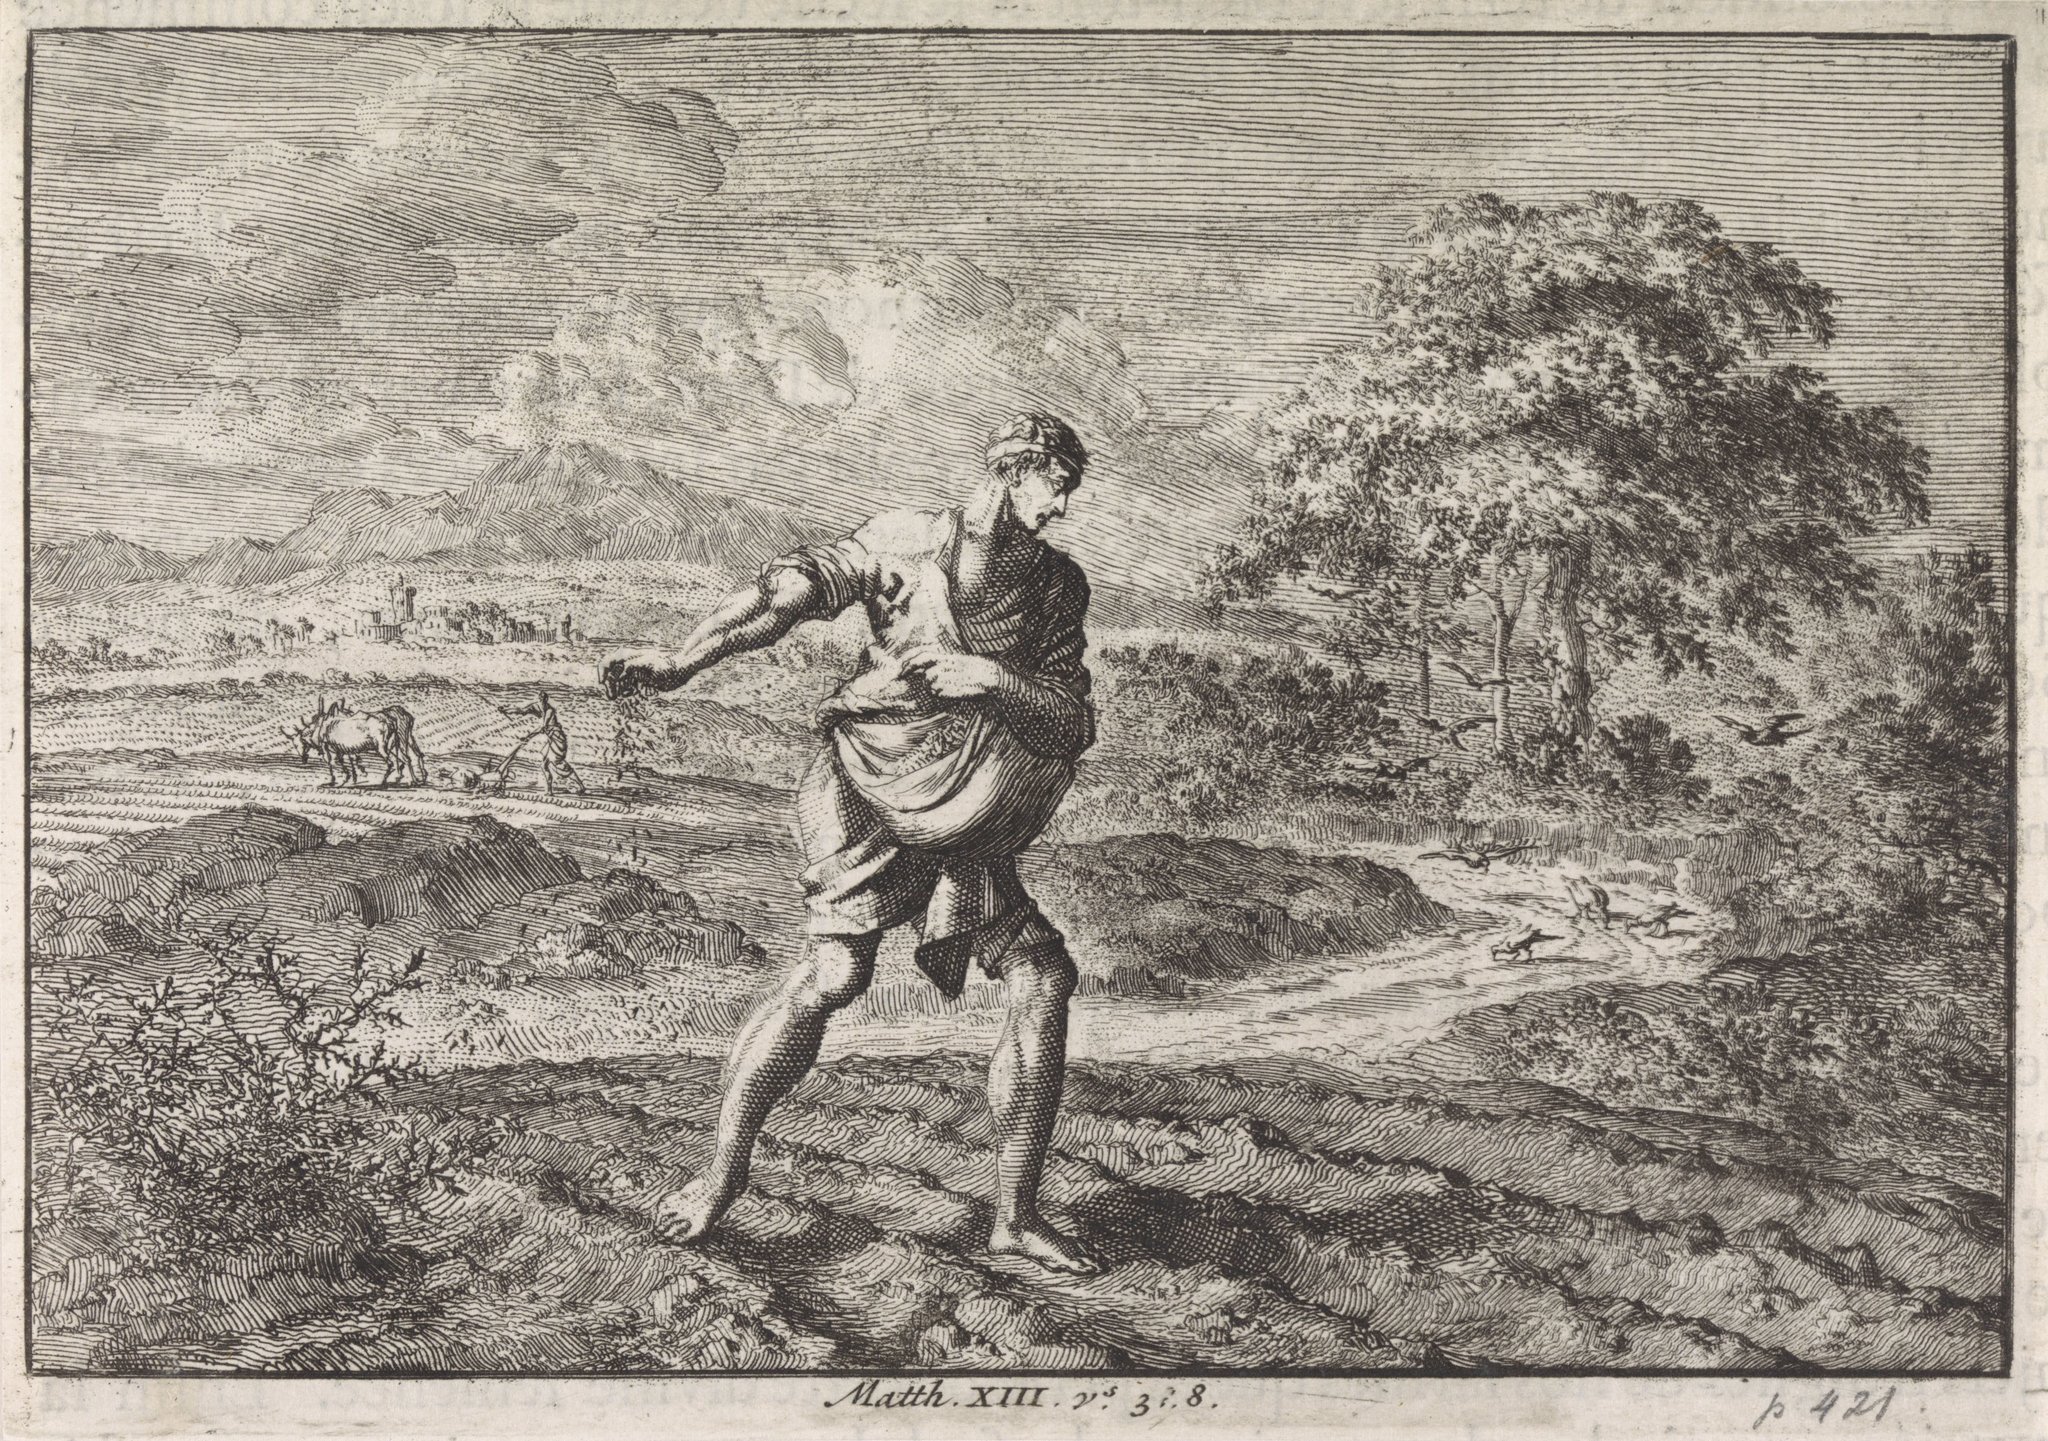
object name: print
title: Gelijkenis van de zaaier en het koninkrijk der hemelen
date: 1703-1762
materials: paper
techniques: etching, letterpress printing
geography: haarlem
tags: the sower ~ parable of christ (matthew 13:3-9; mark 4:3-9; luke 8:5-8)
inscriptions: collector's mark: Lugt 2228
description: De prent komt een eerste keer voor als boekillustratie voor David Martin. Historie des Ouden en Nieuwen Testaments. Amsterdam, Pieter Mortier, 1703. Deel II. De boekillustraties voor de Mortierbijbel hebben verschillende staten en kopieën, waarbij de chronologische volgorde moeilijk te achterhalen valt. Als boekillustraties werden ze bovendien herhaaldelijk opnieuw gebruikt voor andere boekwerken.